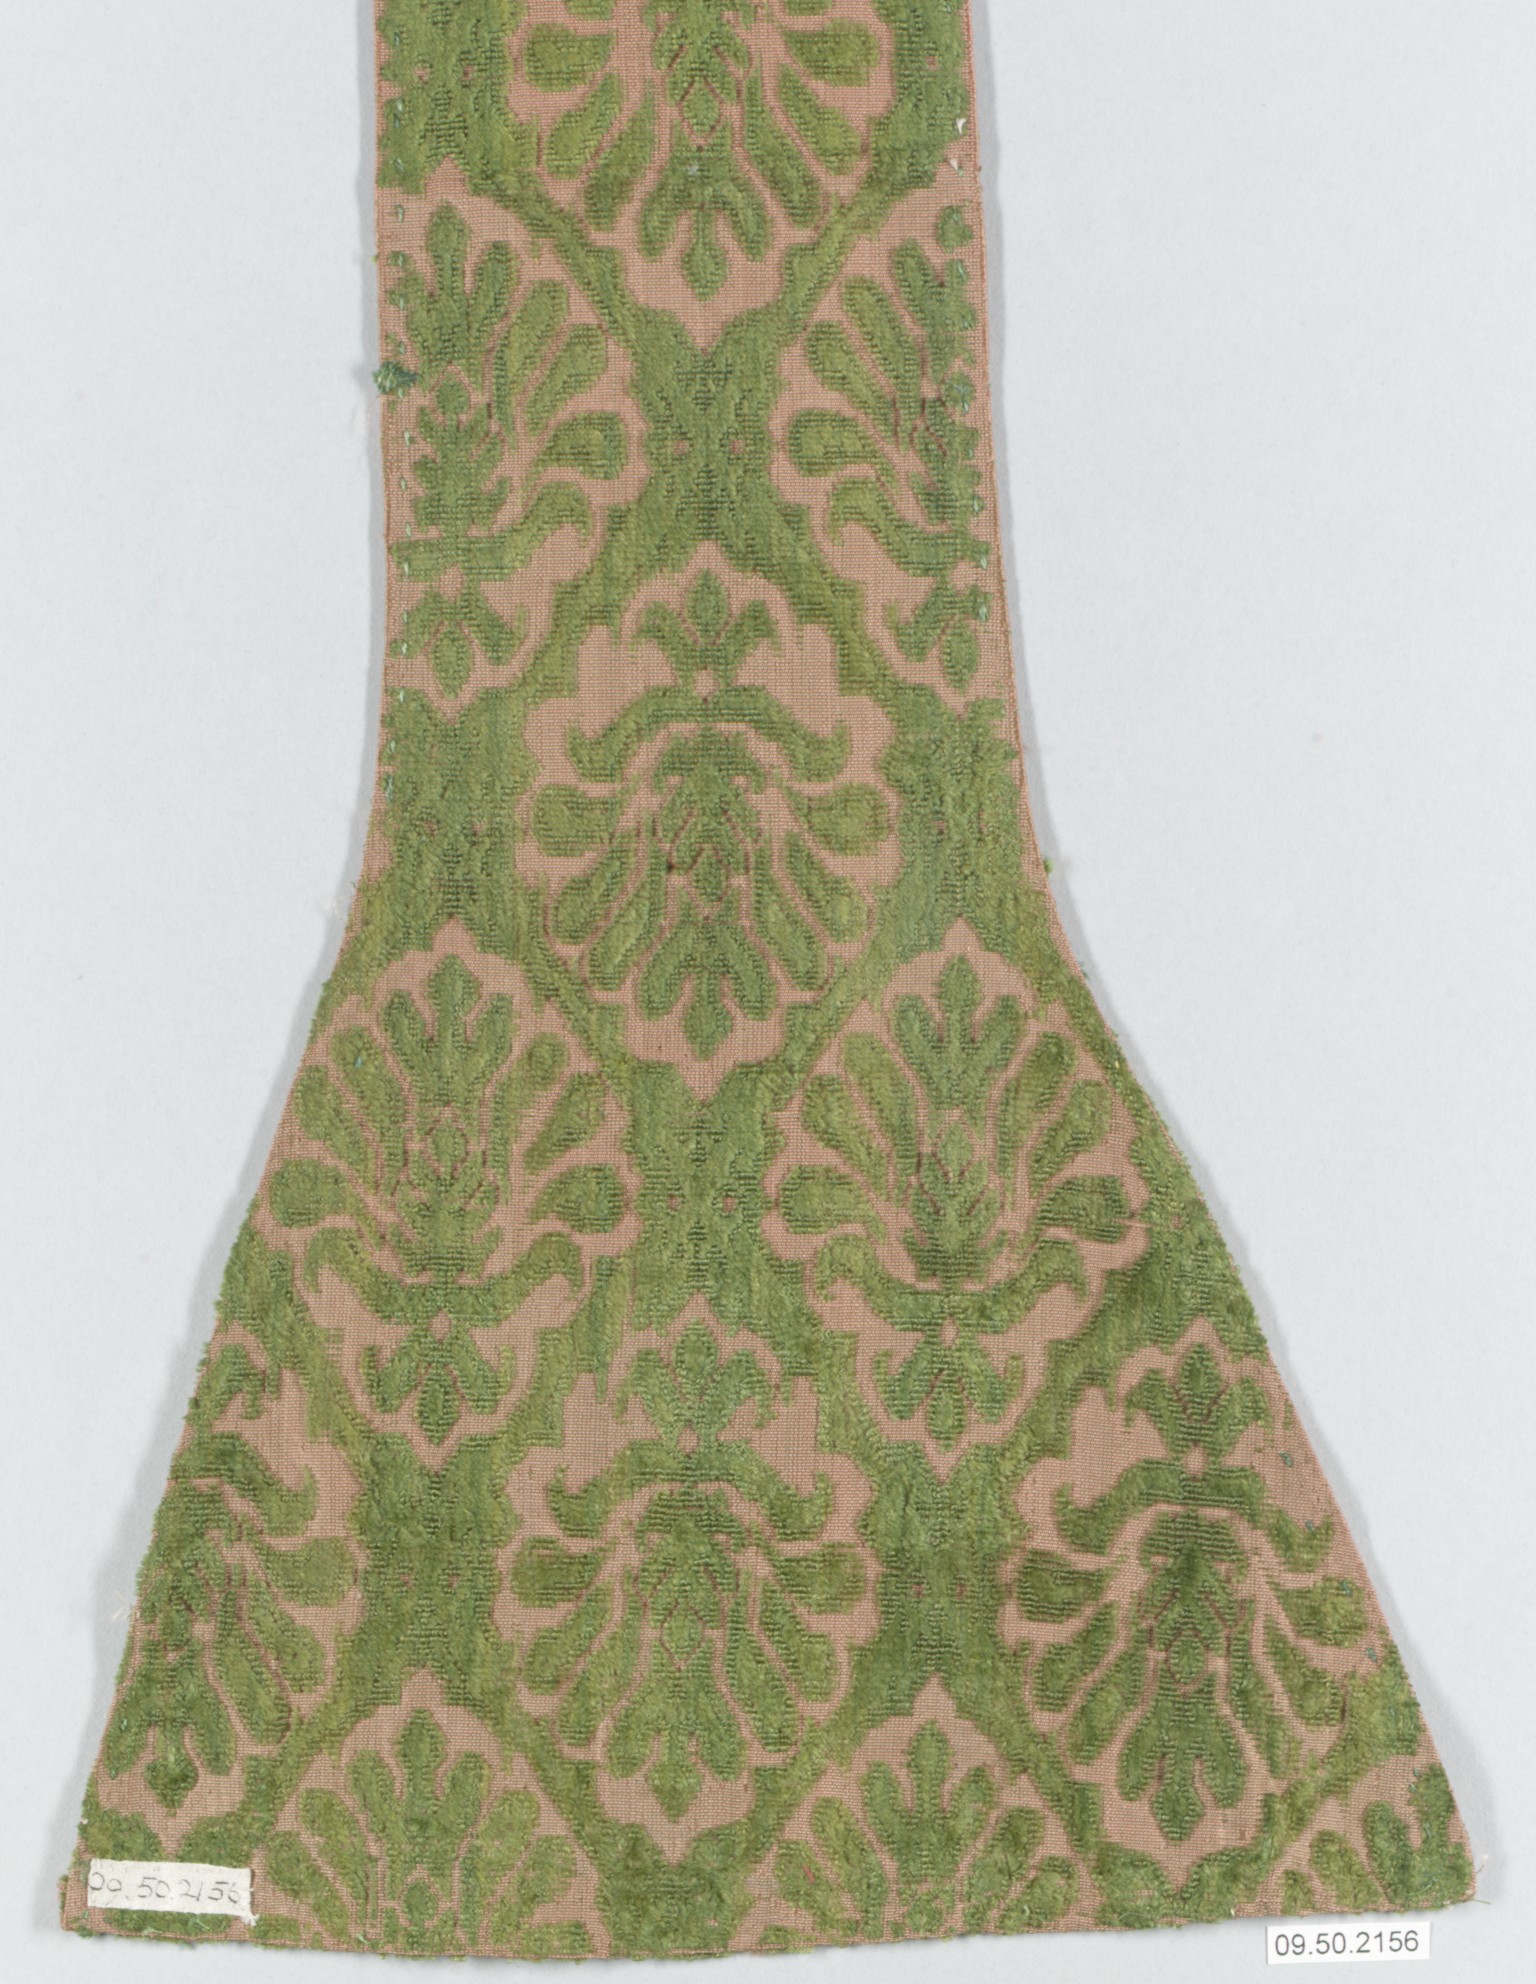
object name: piece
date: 1601-1700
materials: silk